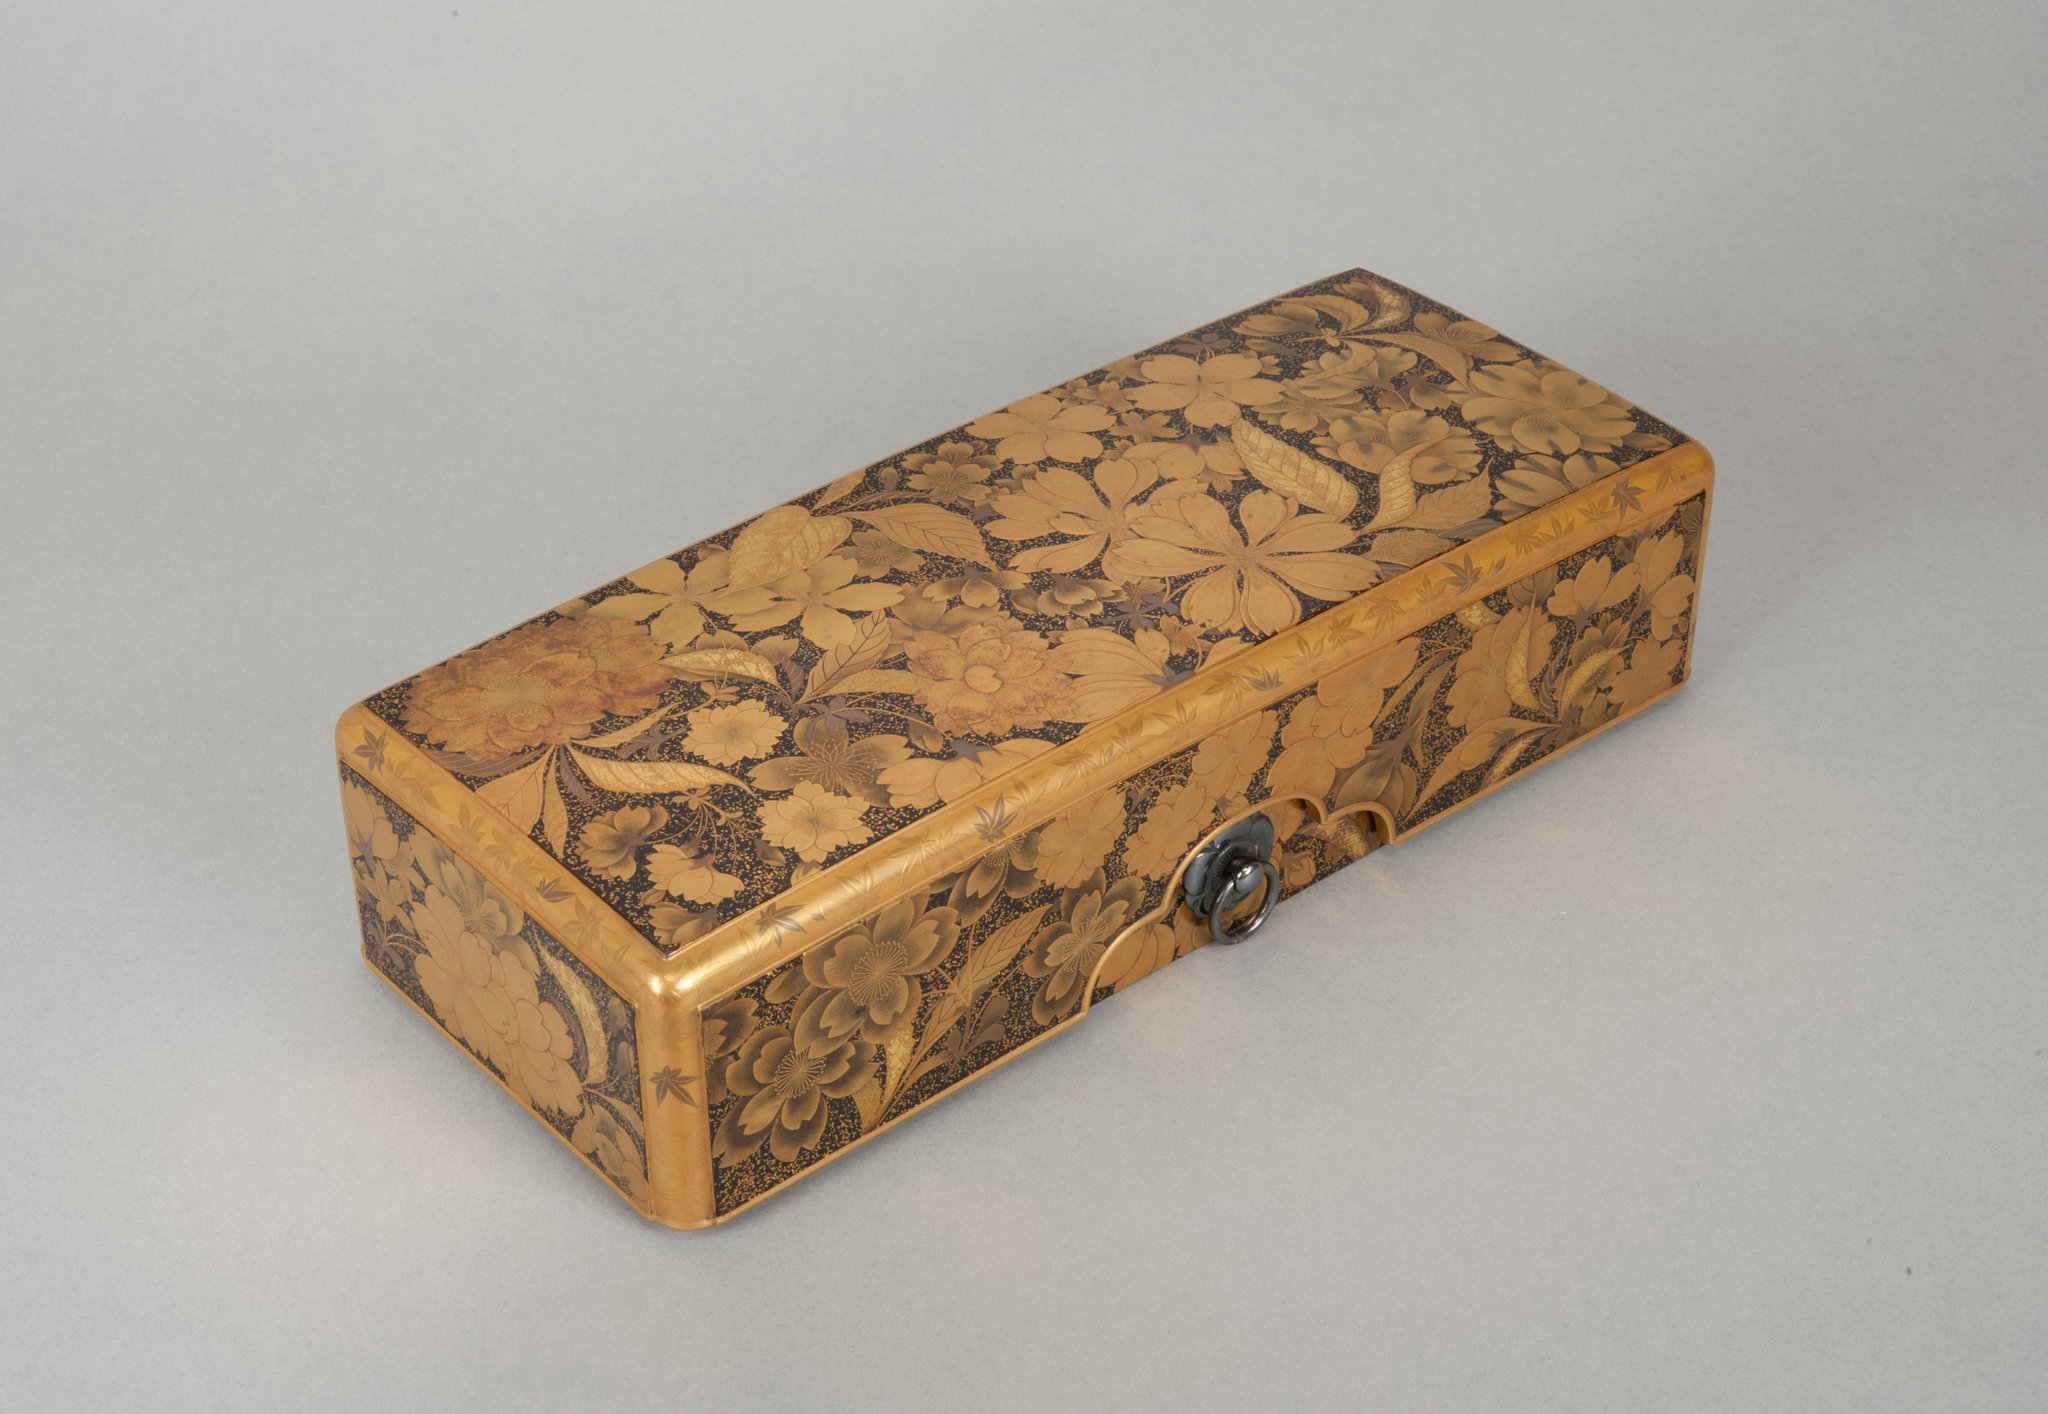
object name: letter box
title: Letter Box (Fumibako) with Design of Cherry Blossom and Maple Leaf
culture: japanese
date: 1701-1800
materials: gold, lacquer, silver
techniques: polish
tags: flowers,leaves